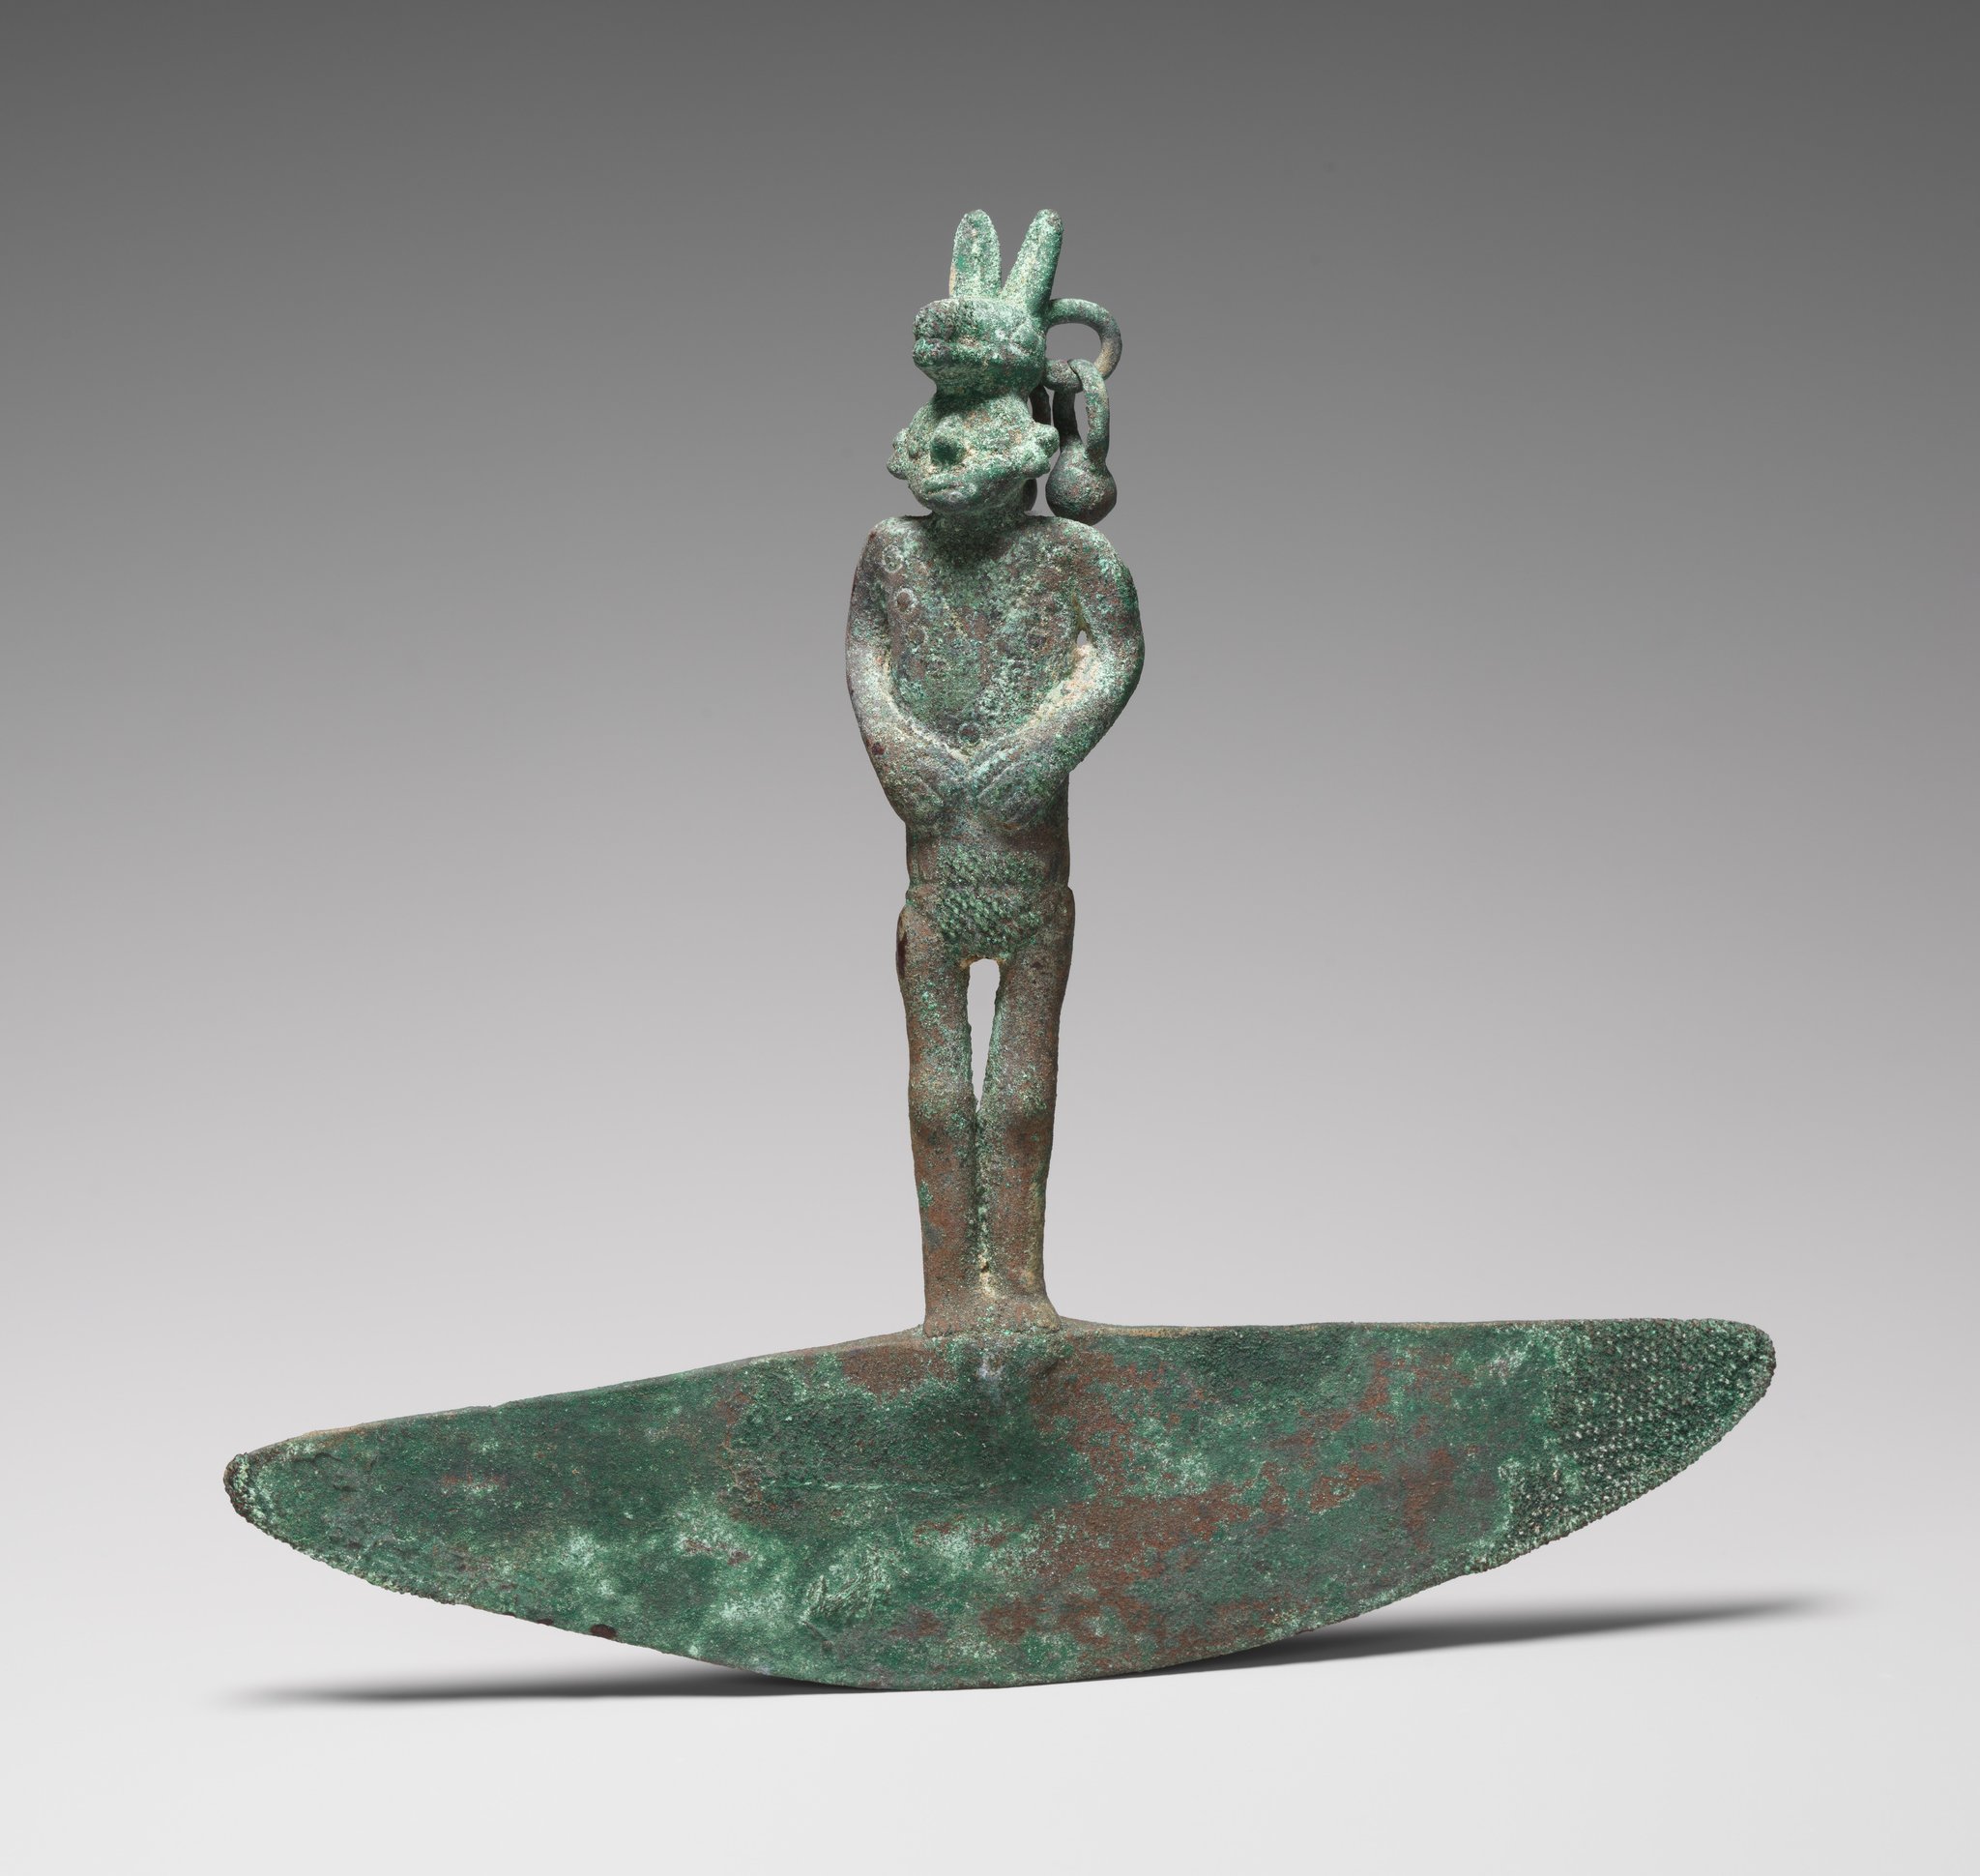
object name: knife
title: Ornamented Knife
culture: inca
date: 1401-1600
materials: copper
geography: peru